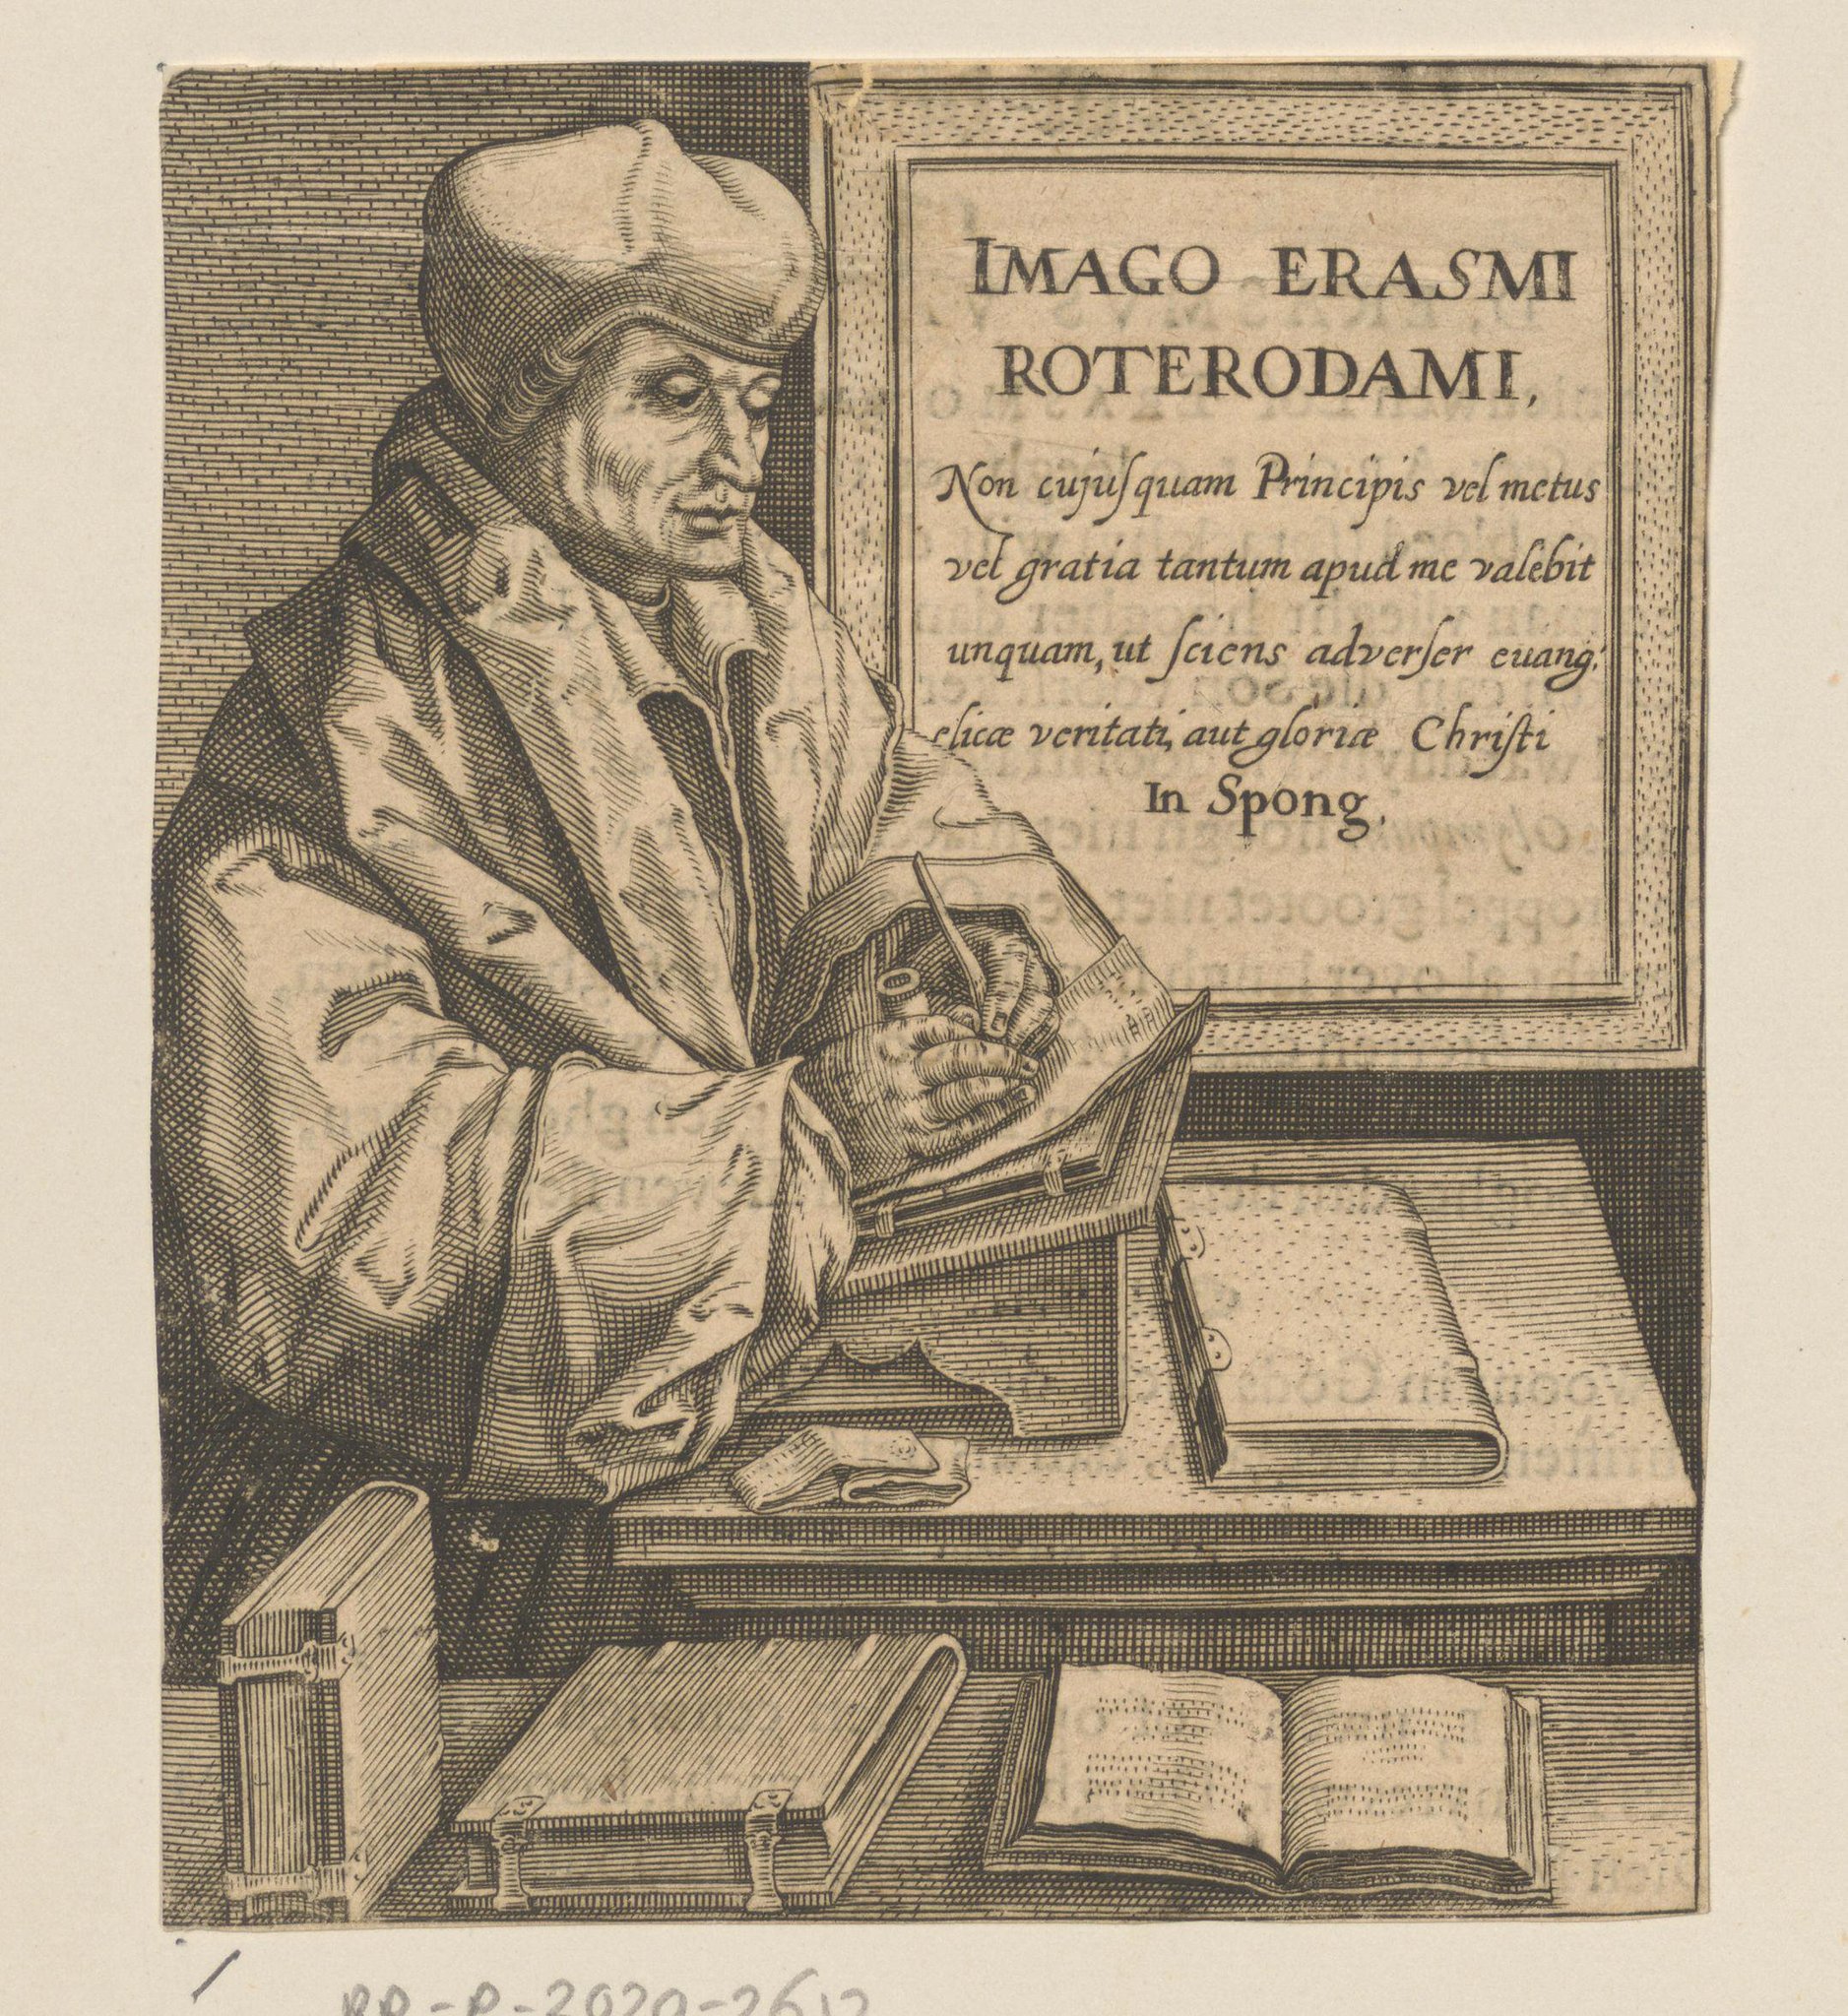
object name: book illustration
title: Portret van Desiderius Erasmus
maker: Anonymous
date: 1600-1670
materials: paper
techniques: engraving, letterpress printing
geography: northern netherlands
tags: rotterdam, desiderius erasmus, handwriting, writing as activity, historical persons, book, scholar, philosopher (+ portrait of scholar, scientist), secretary, scribe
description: Prent komt uit een onbekende publicatie.